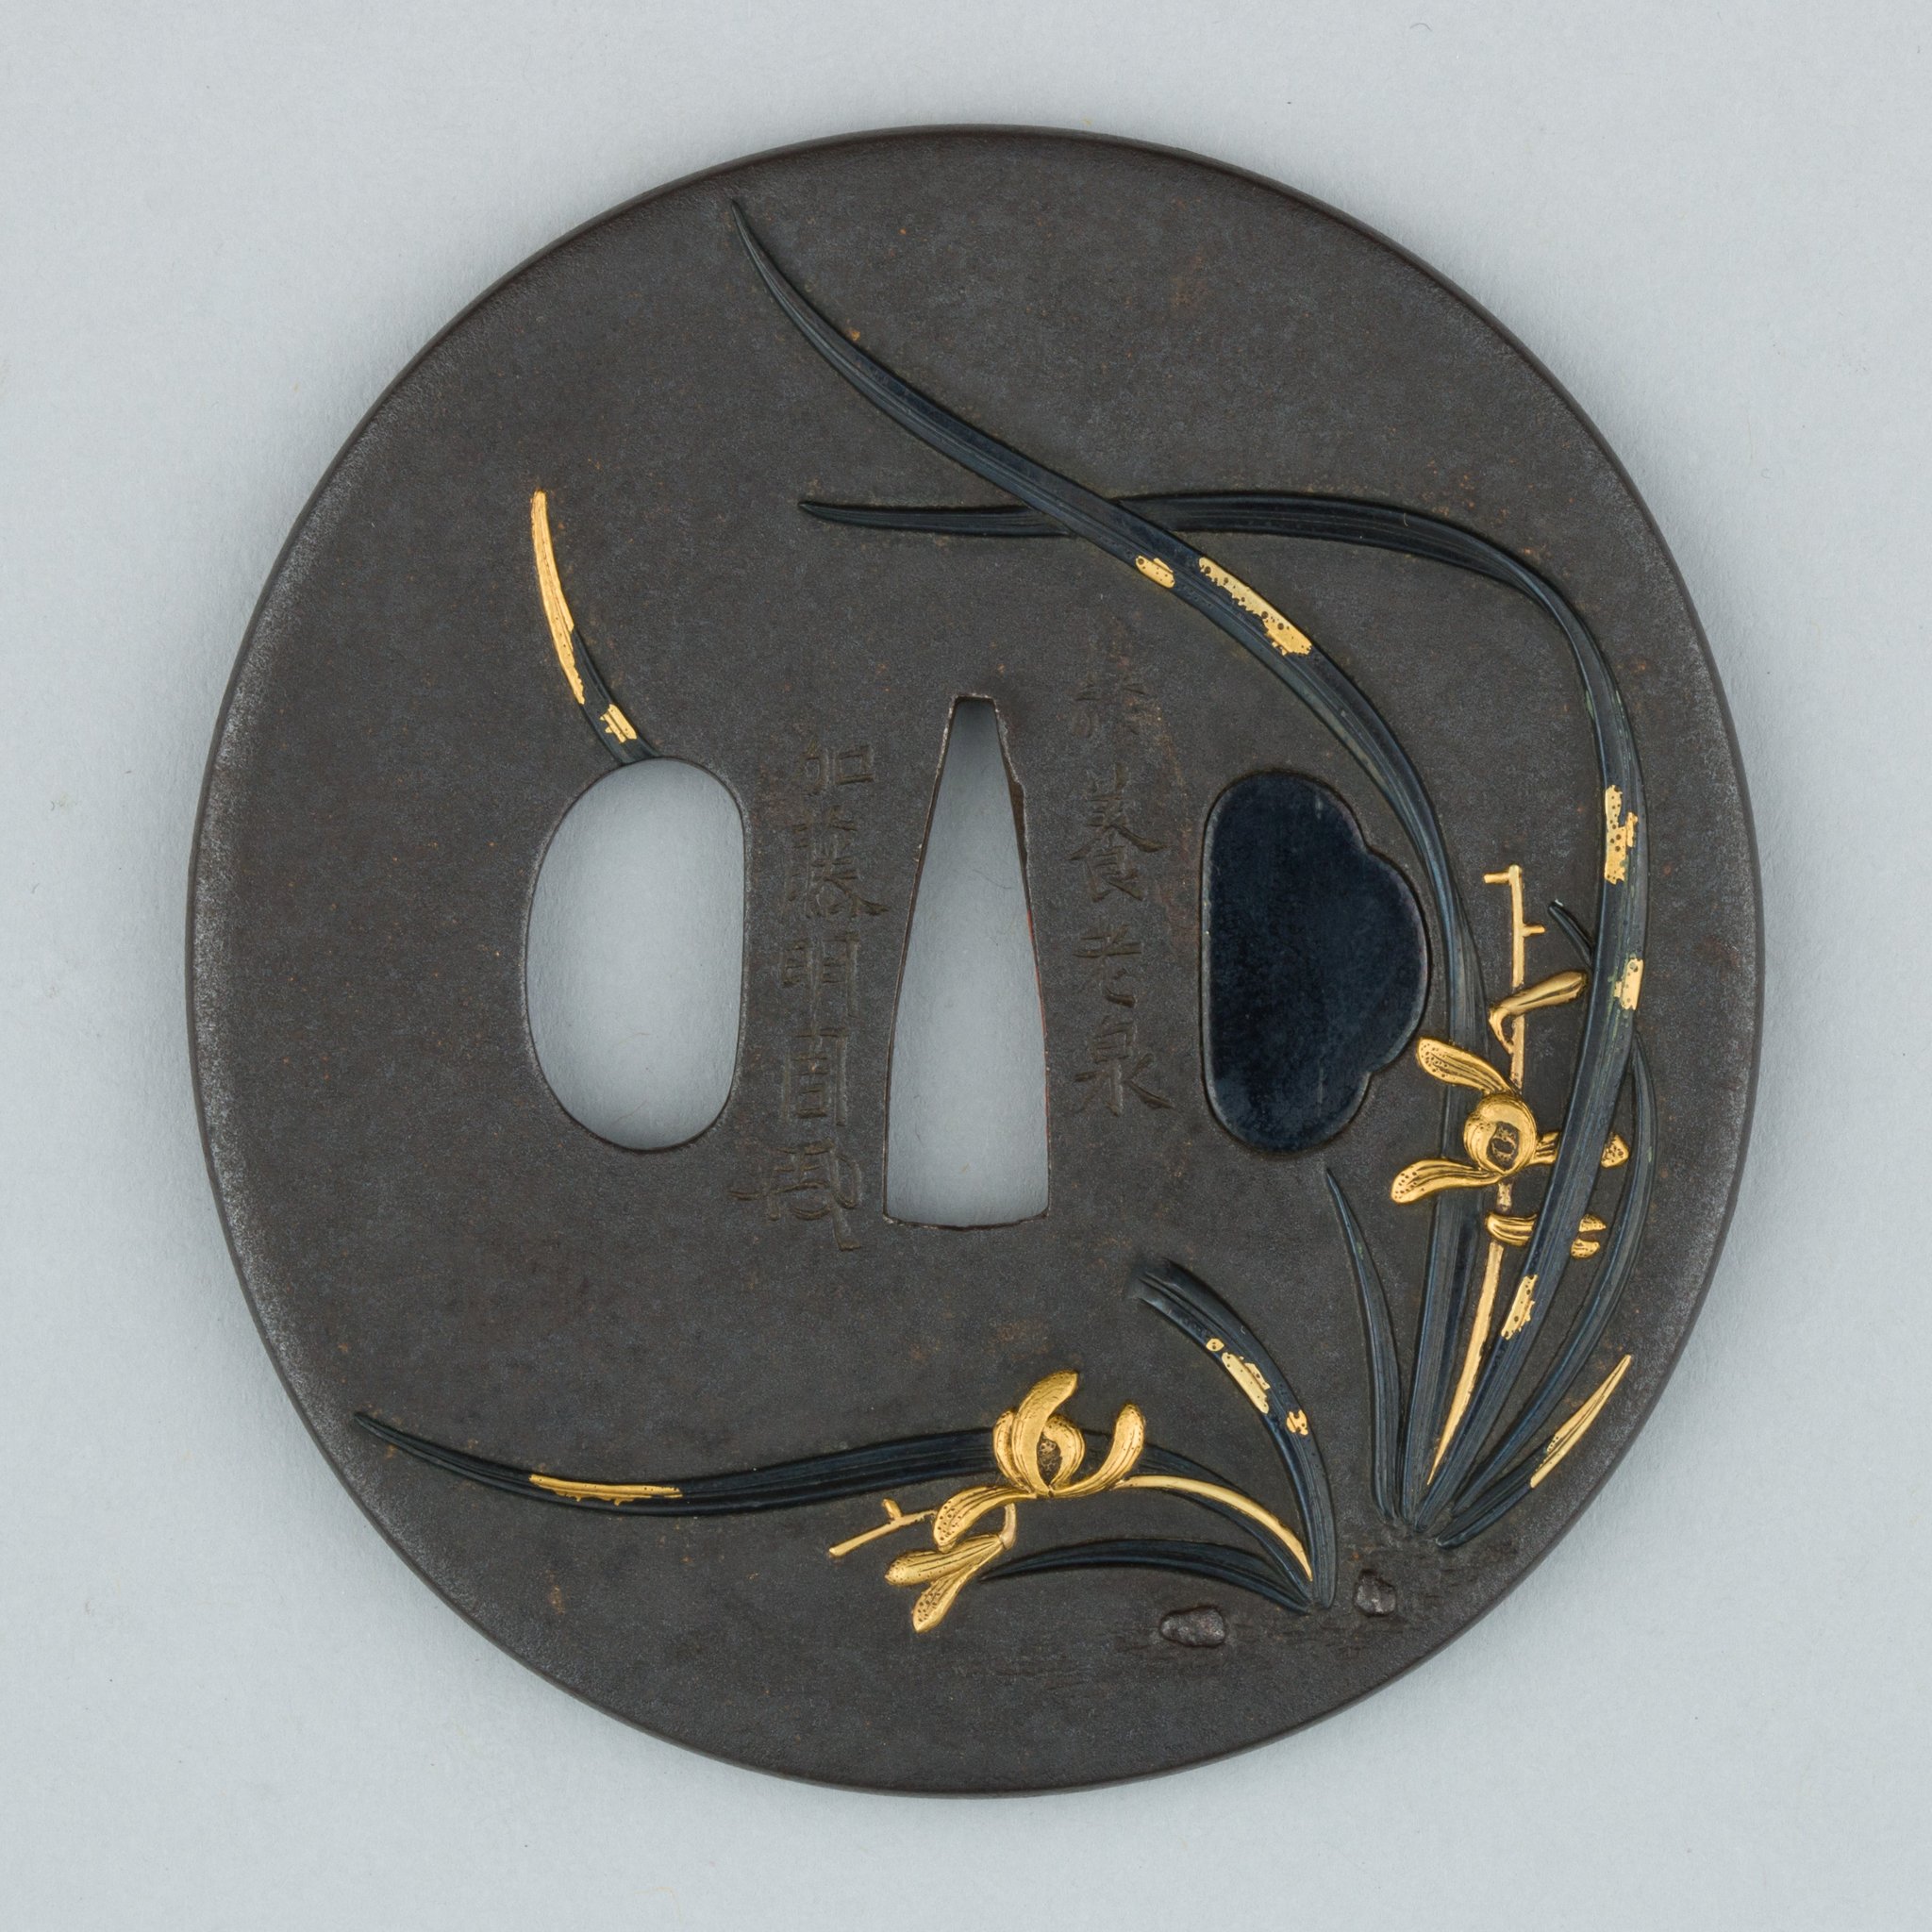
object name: sword guard tsuba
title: Sword Guard (Tsuba)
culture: japanese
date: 1858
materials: copper, gold alloy, gold, iron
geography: japan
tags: plants